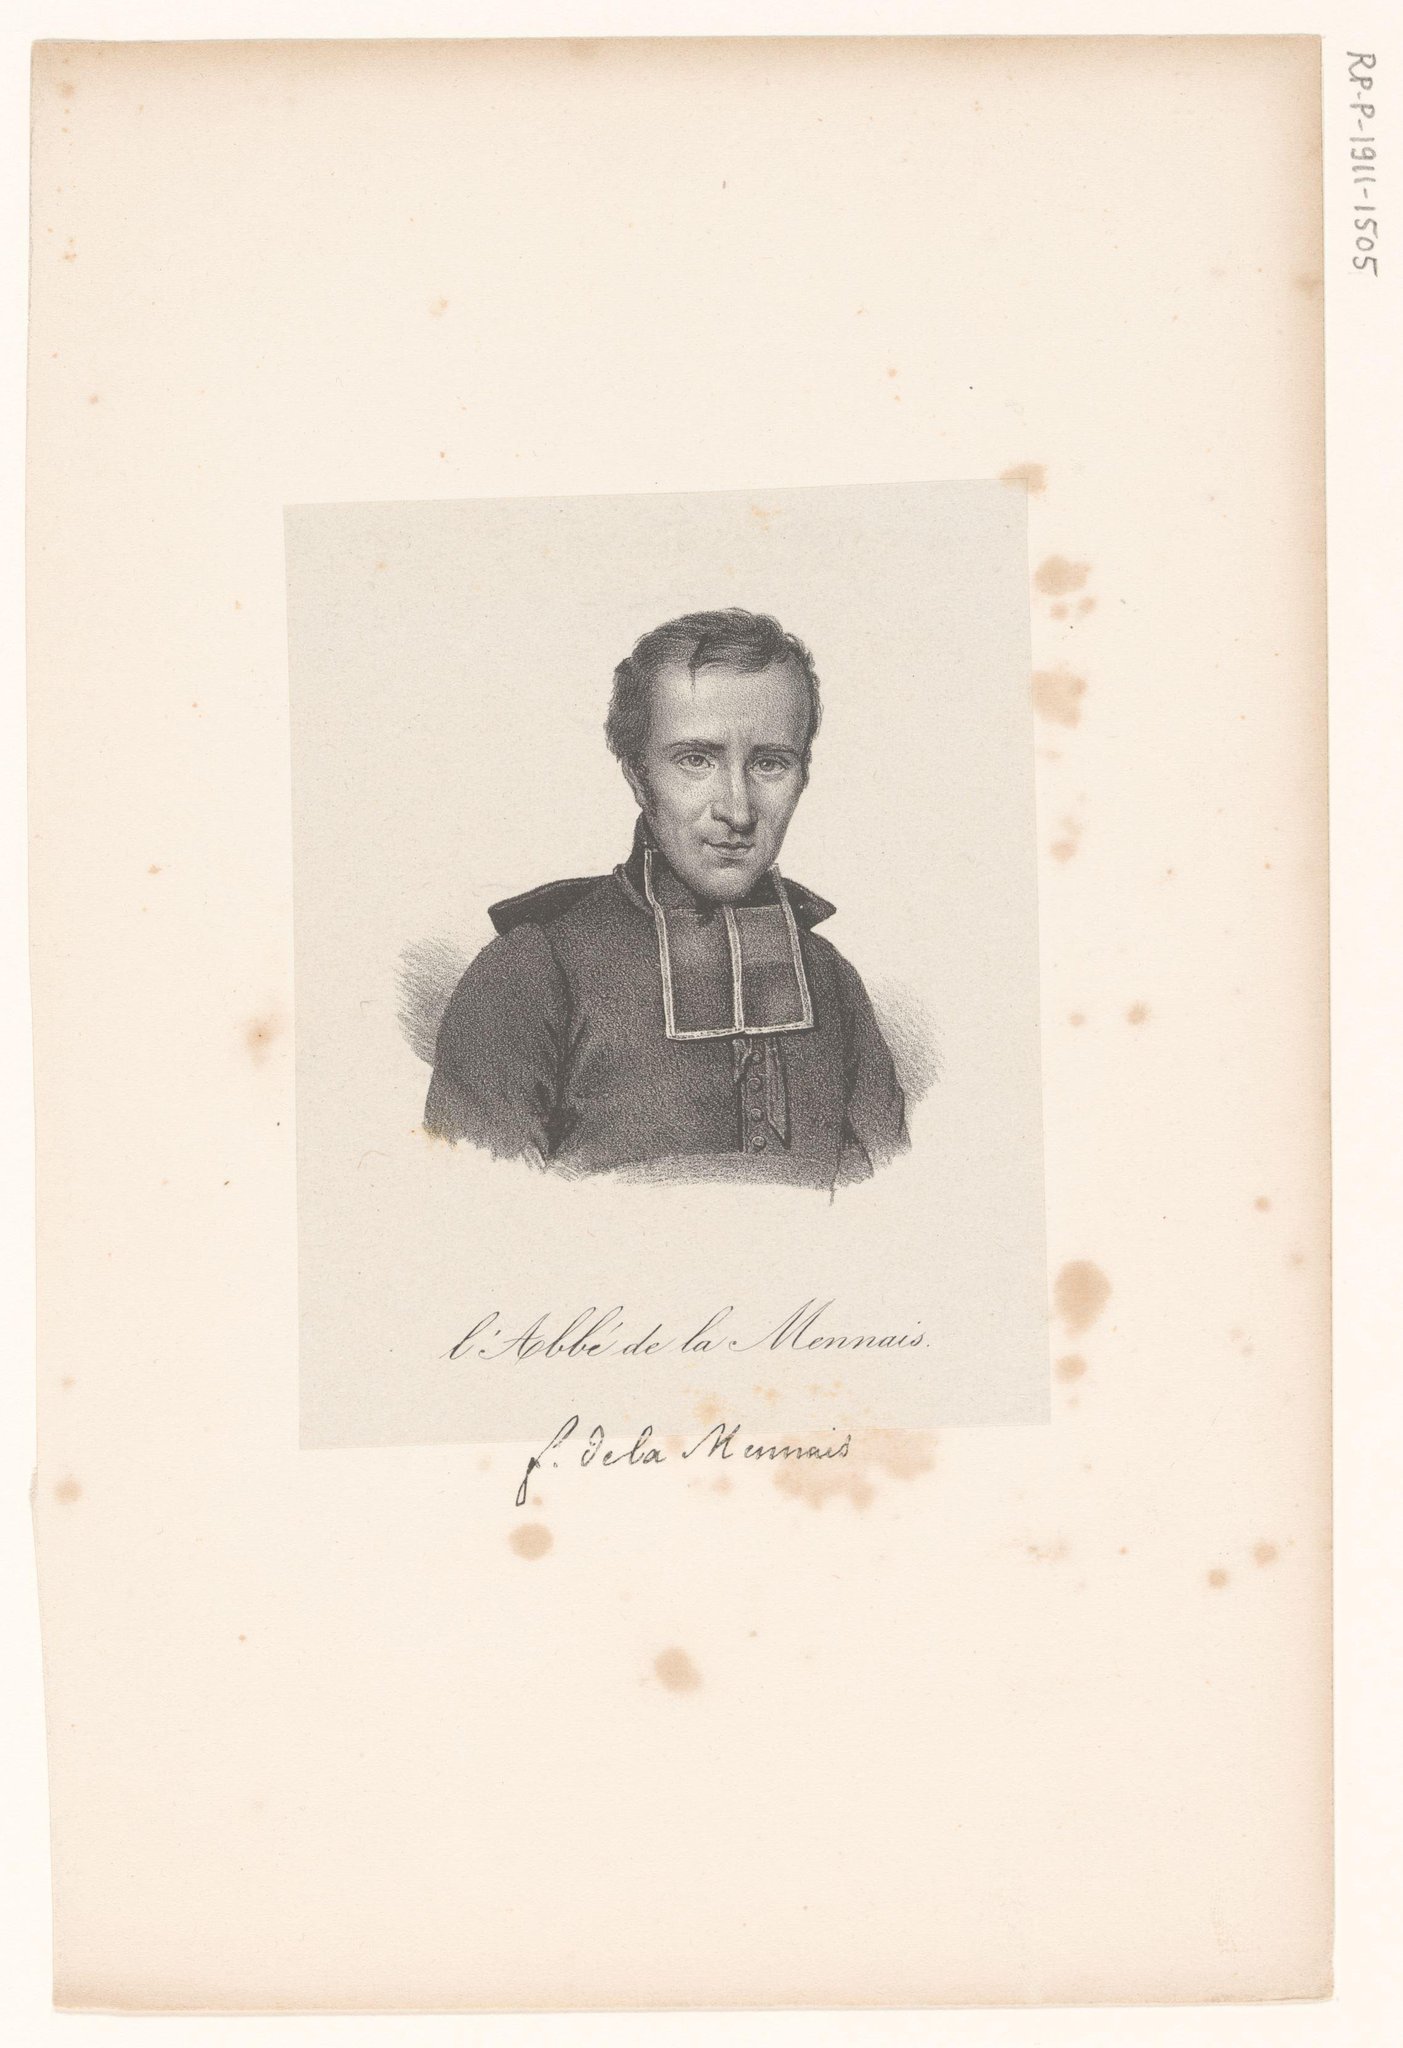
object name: print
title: l'Abbé de la Mennais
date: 1818-1842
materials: paper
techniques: lithograph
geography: paris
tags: paris, priest, historical persons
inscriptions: collector's mark: Lugt 2228a